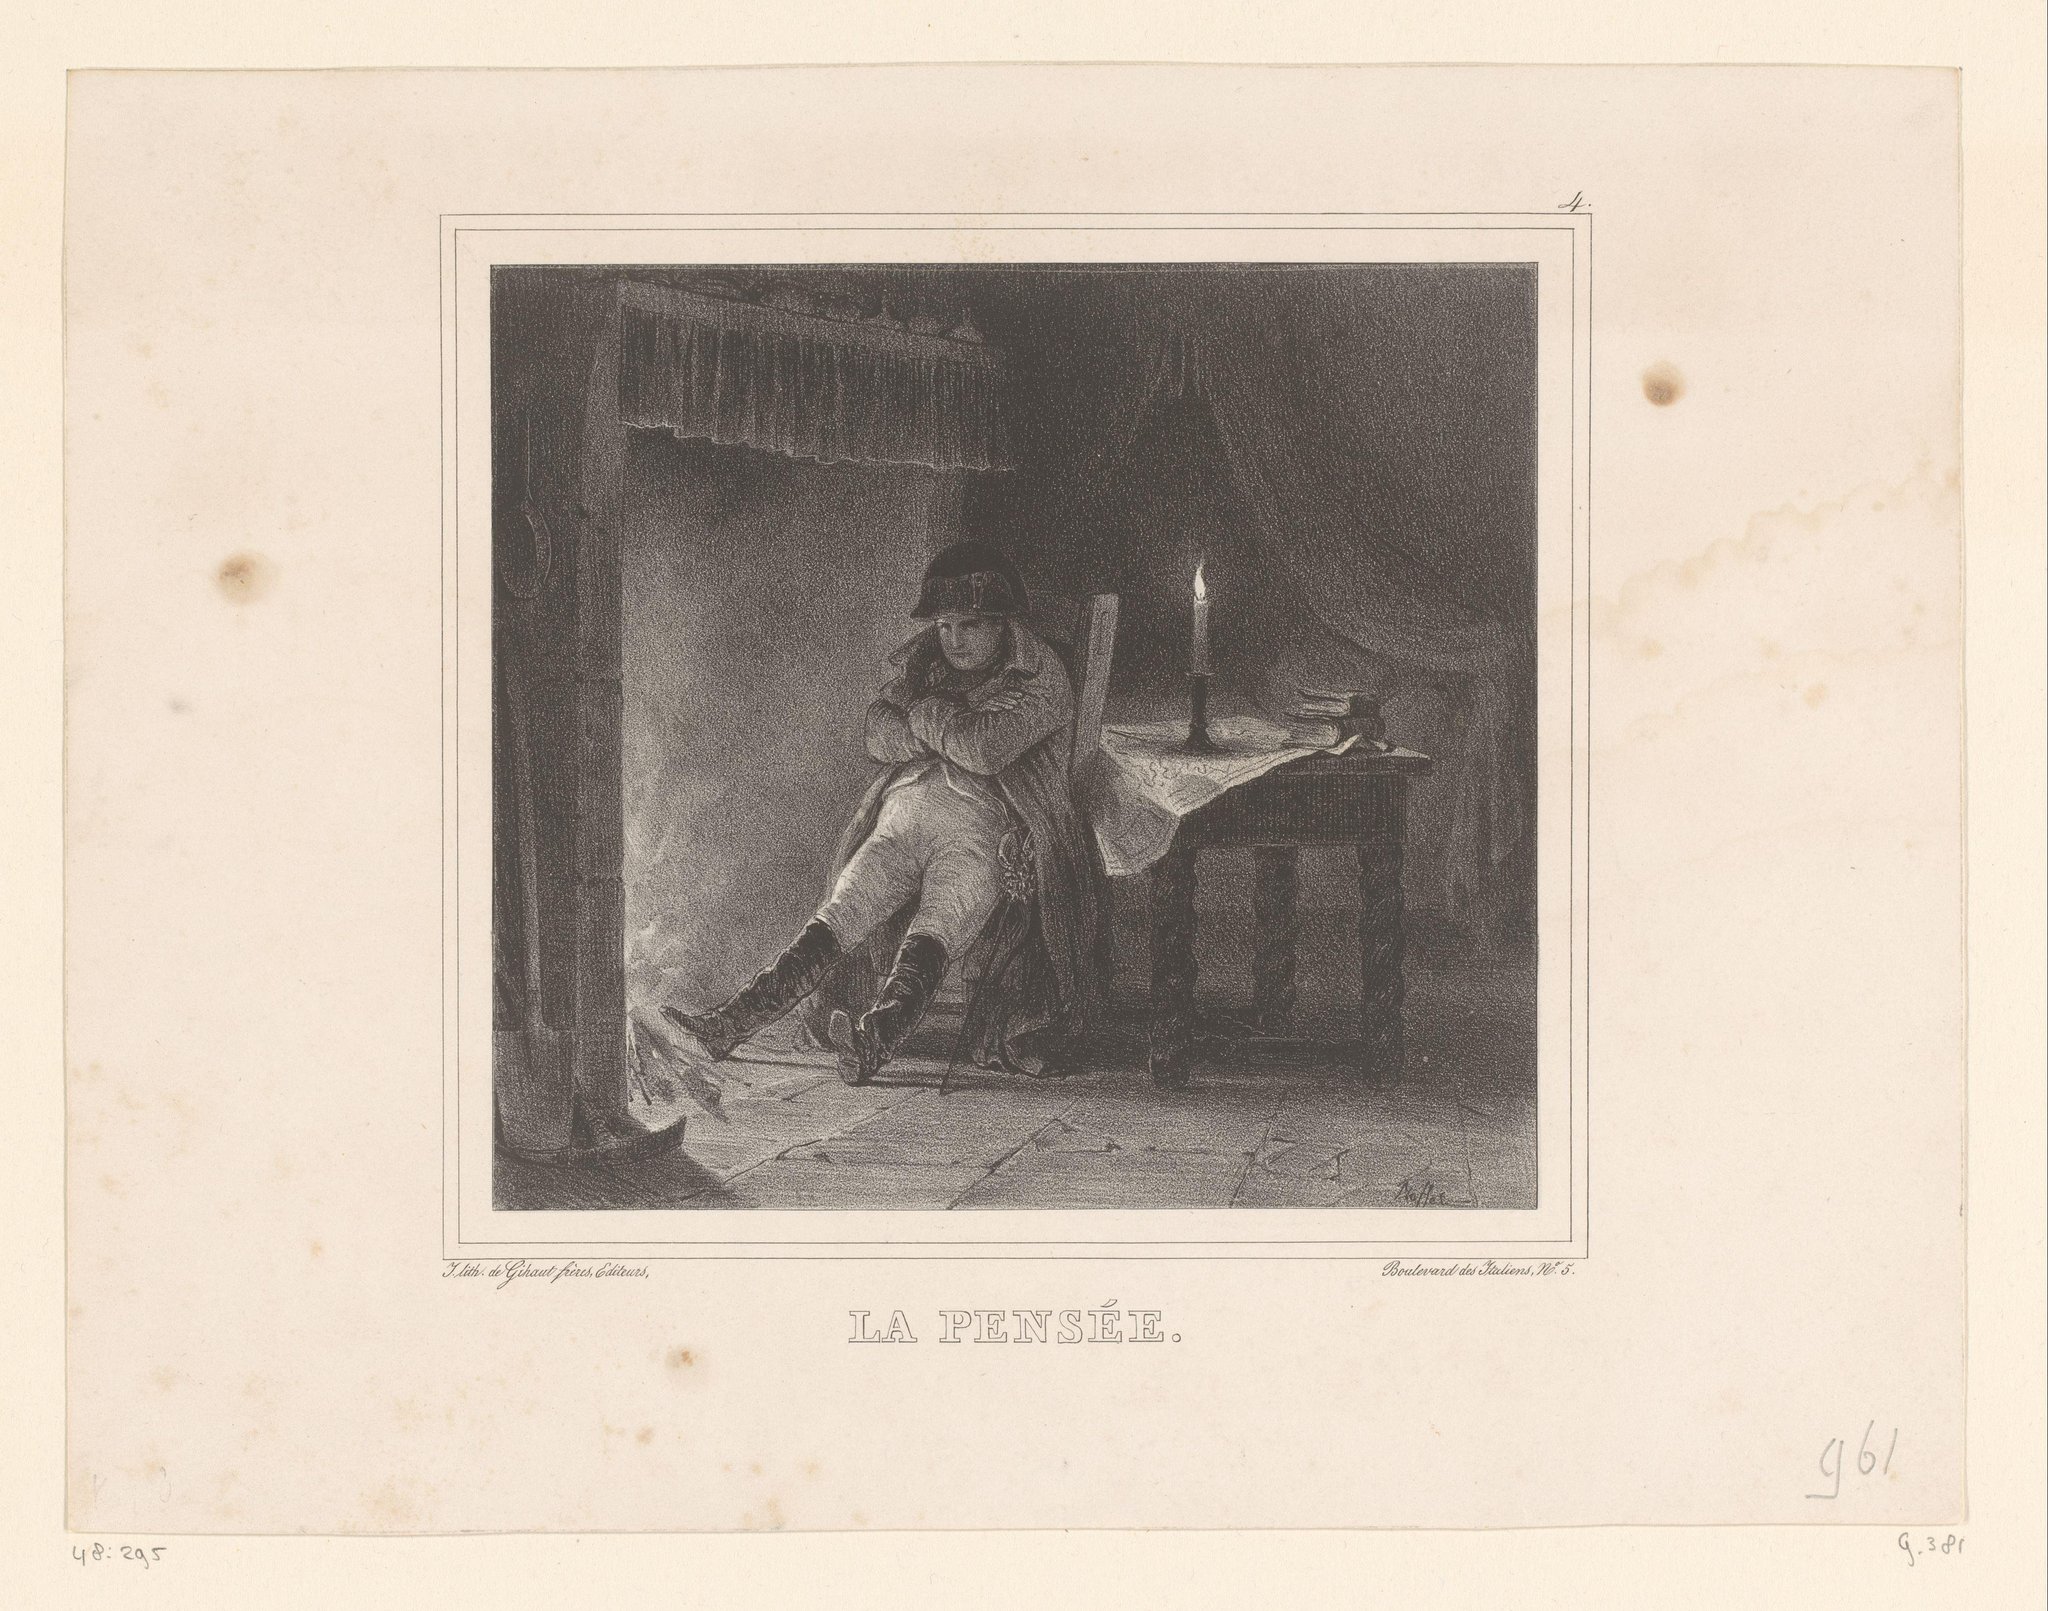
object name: print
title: Album met twaalf prenten van Auguste Raffet uit 1834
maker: denis auguste marie raffet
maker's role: draughtsman, print maker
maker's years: 1804-1860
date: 1834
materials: paper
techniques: lithograph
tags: napoleon i (emperor of the french), open hearth, fire-place, emperor, candlestick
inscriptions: collector's mark: Lugt 2228